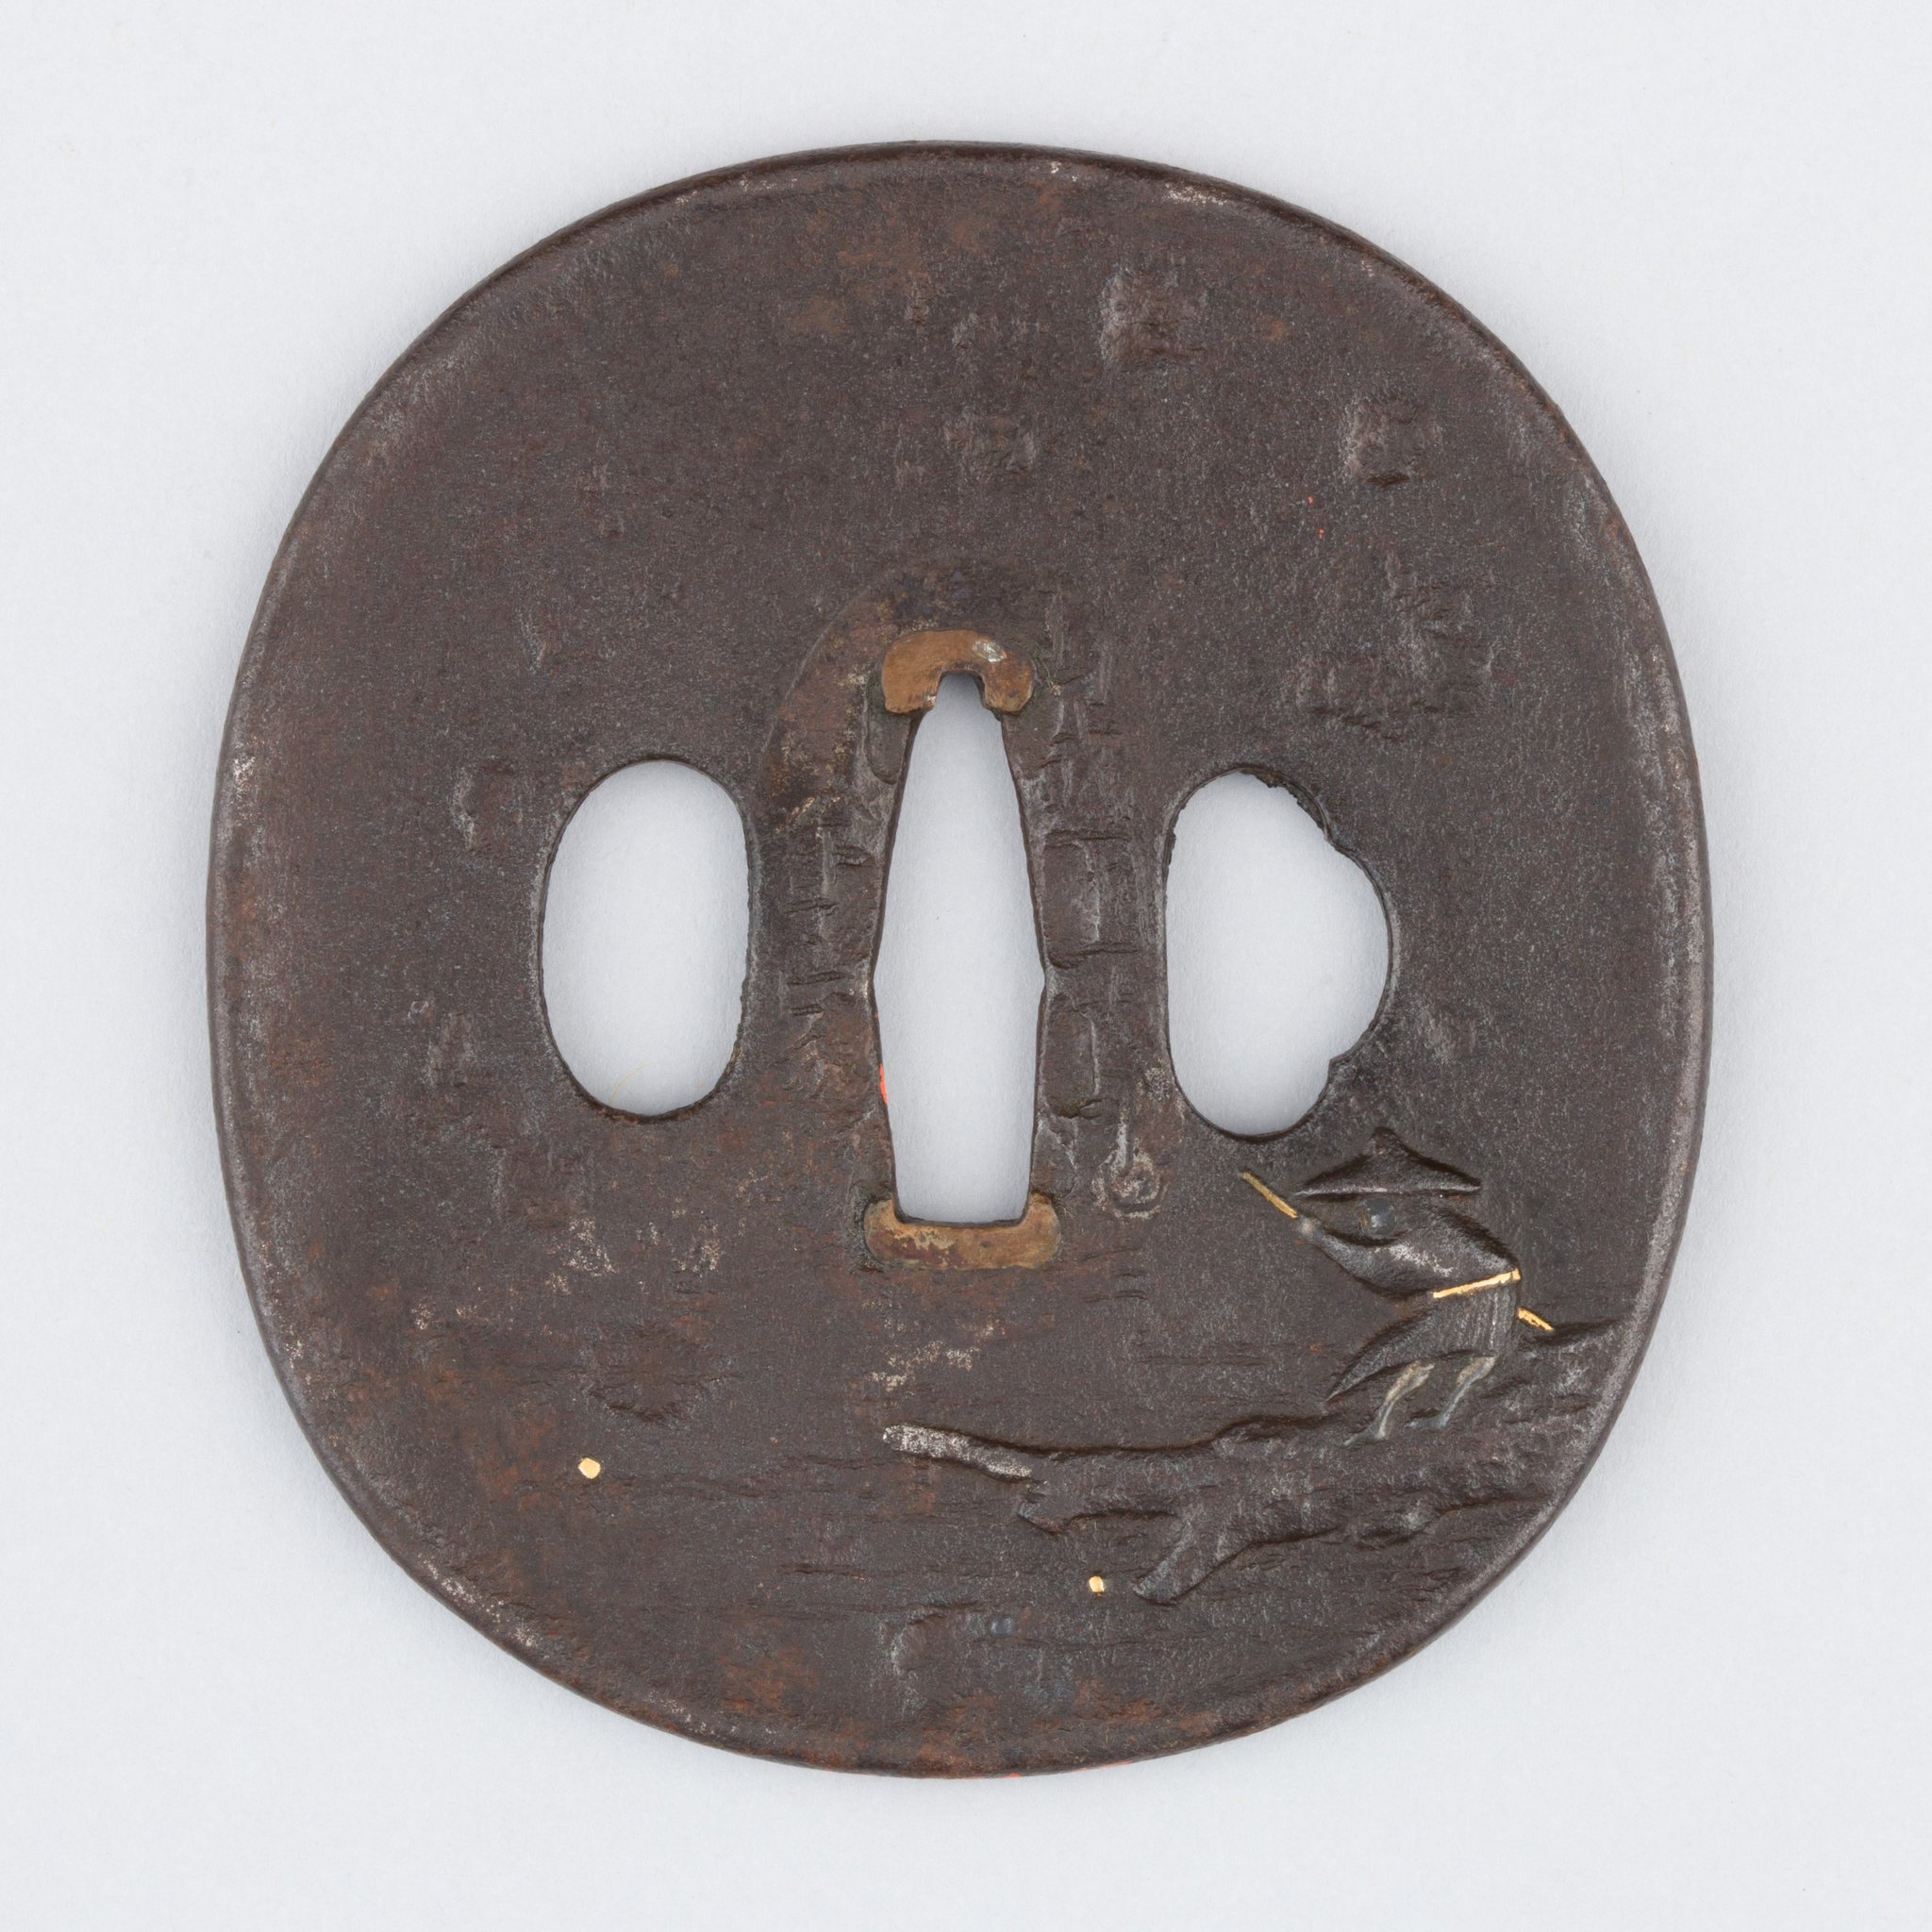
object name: sword guard tsuba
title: Sword Guard (Tsuba)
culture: japanese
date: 1615-1868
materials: copper, iron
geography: japan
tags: men